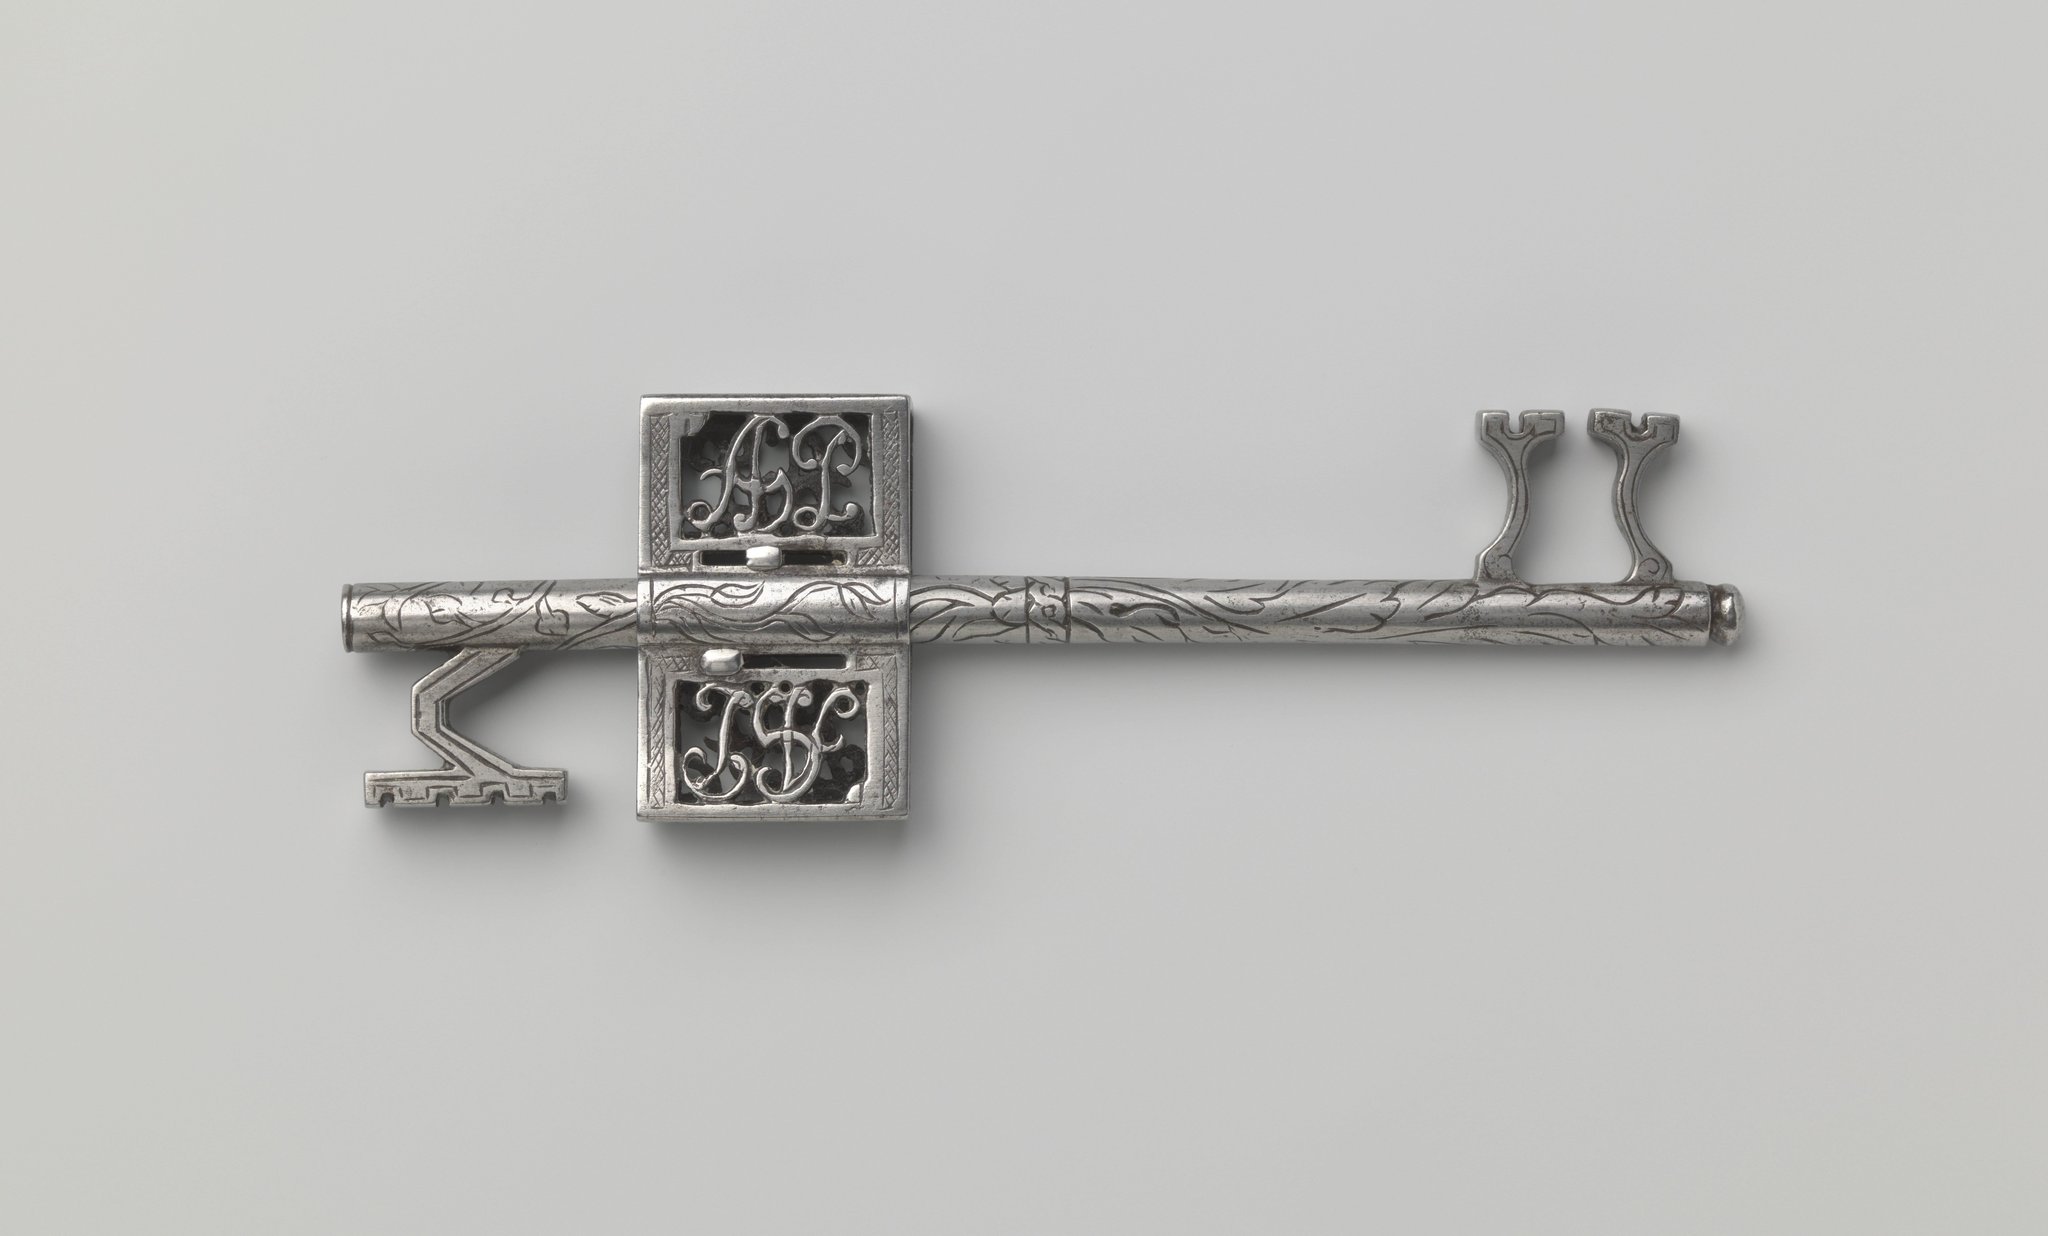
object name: key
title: Sleutel, zogenaamde dubbelsleutel, gegraveerd, met twee baarden en een vierkante but waarin de uitgezaagde initialen AGP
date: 1700-1800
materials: iron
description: Sleutel, zogenaamde dubbelsleutel, gegraveerd,met twee baarden en een vierkante but waarin de uitgezaagde initialen AGP.